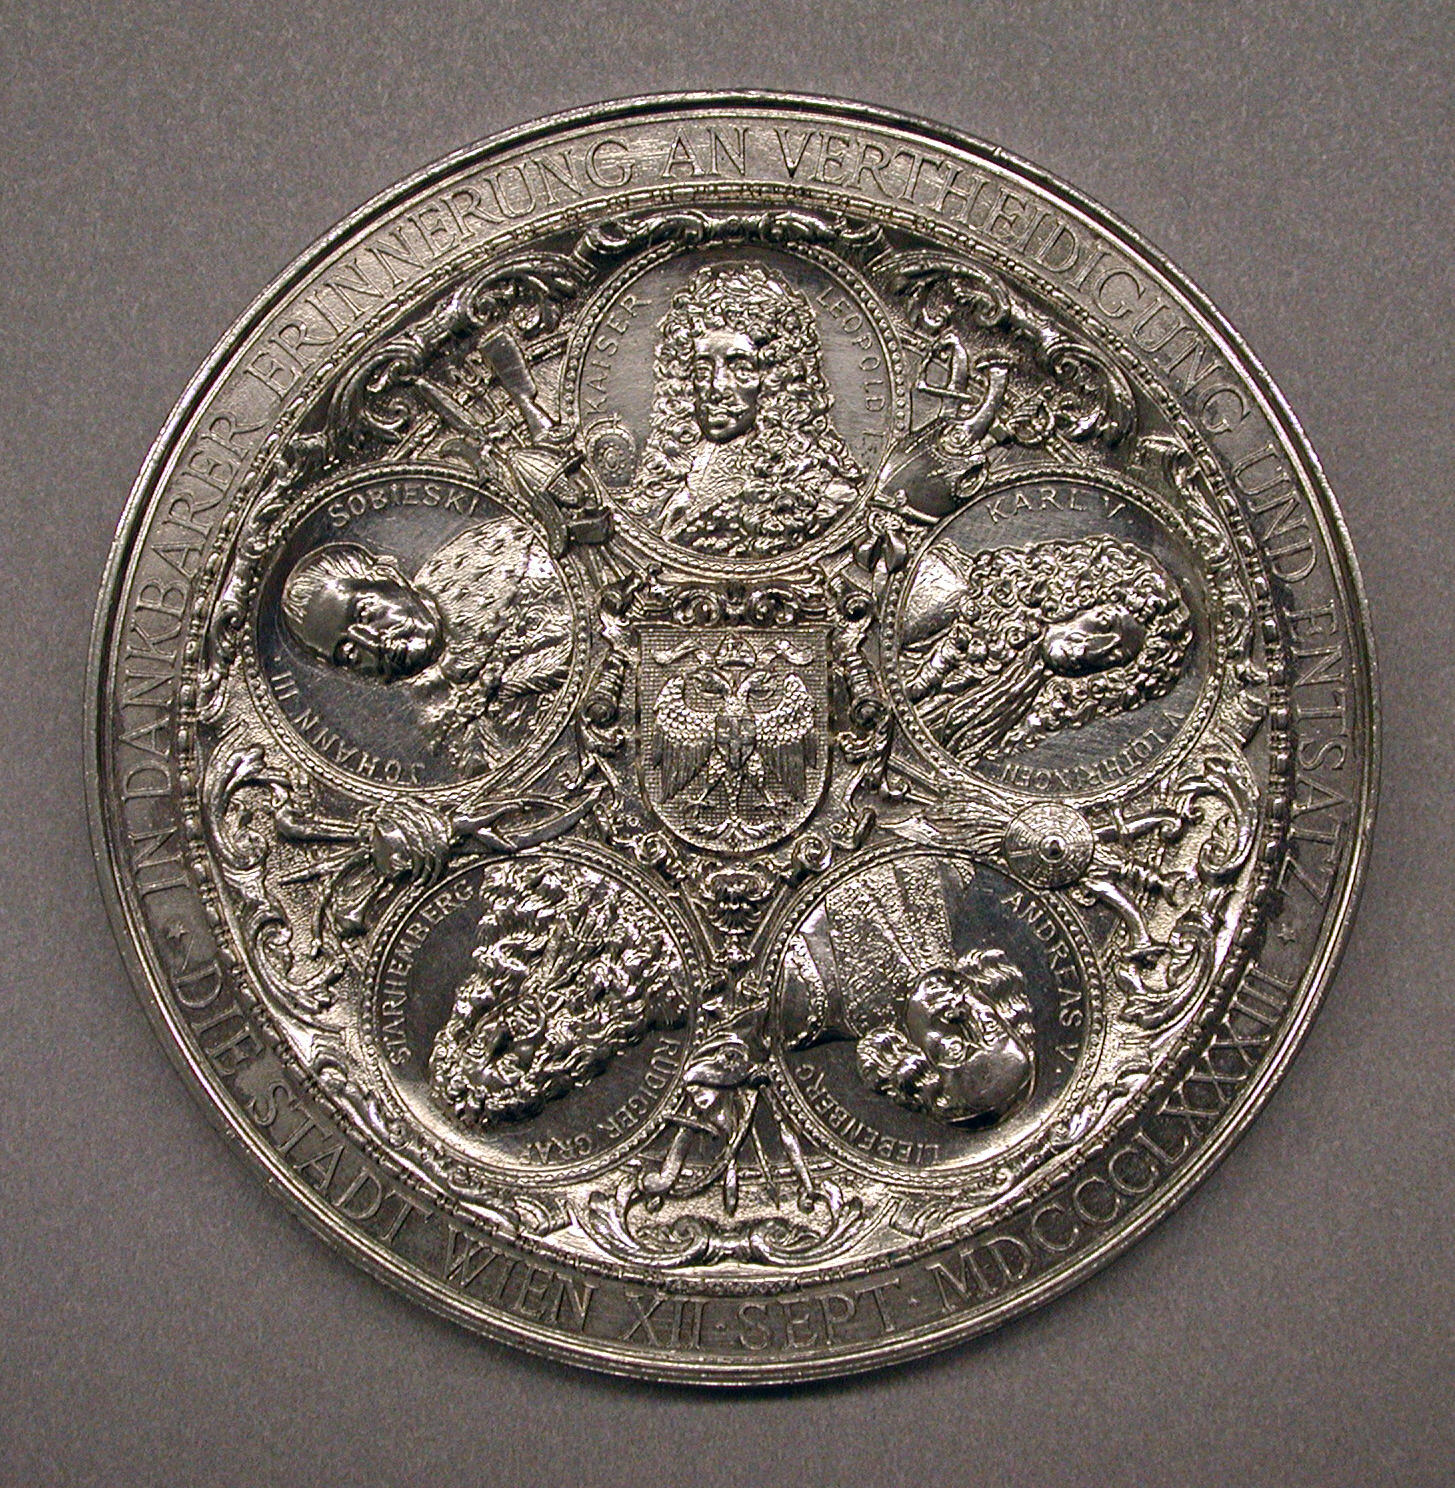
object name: medal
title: Bicentennial of the Siege of Vienna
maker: anton scharff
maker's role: maker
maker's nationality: austrian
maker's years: 1845-1903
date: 1883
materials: bronze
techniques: silvered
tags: men,portraits,coat of arms